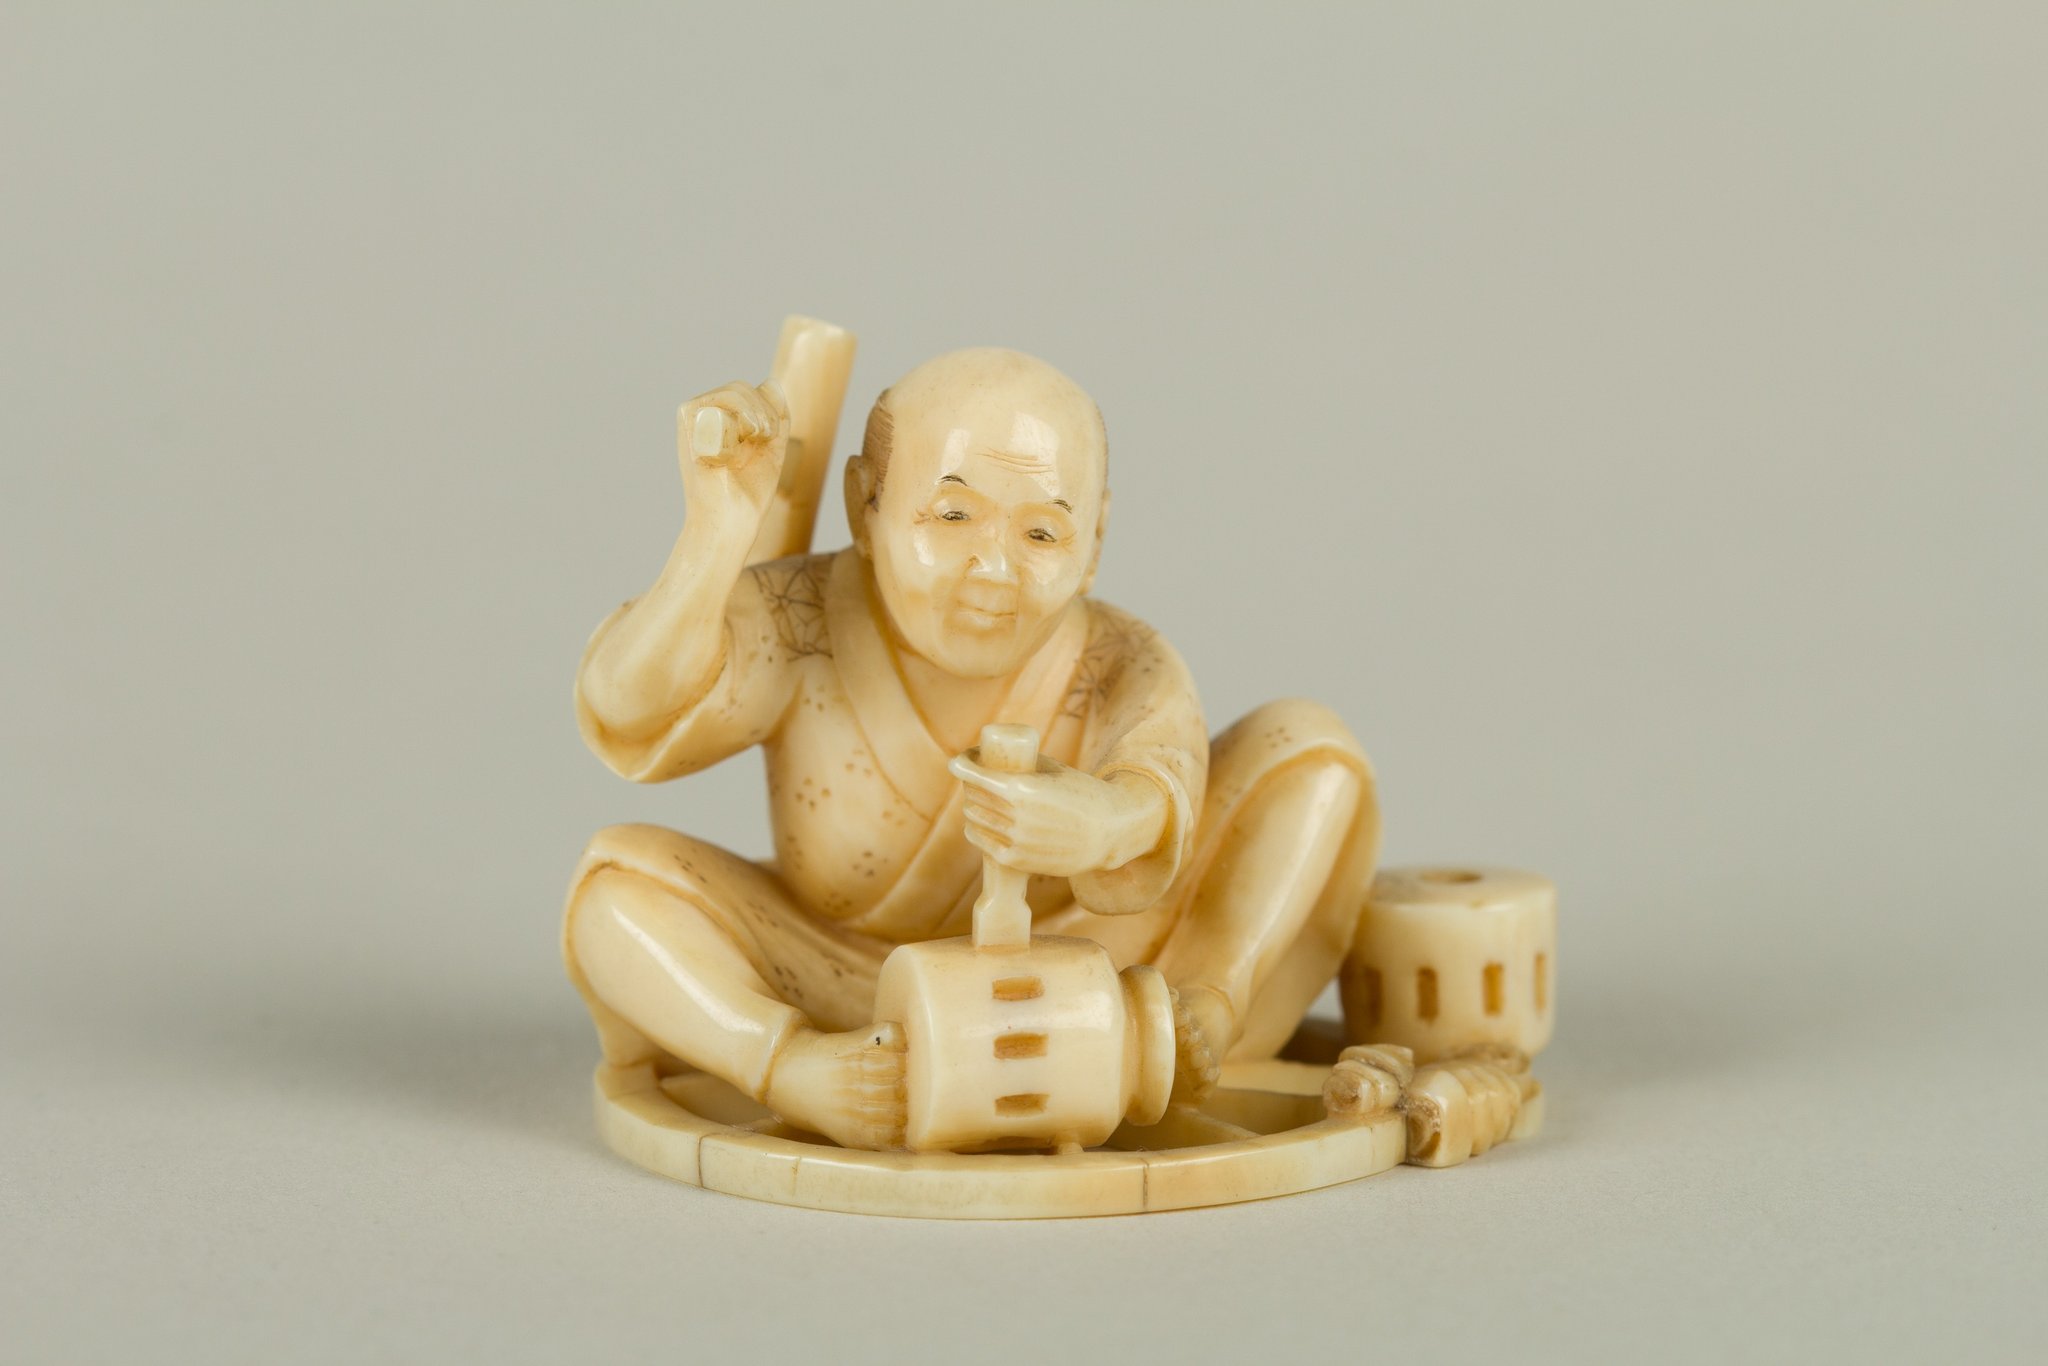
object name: netsuke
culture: japanese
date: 1801-1900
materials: ivory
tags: hammers